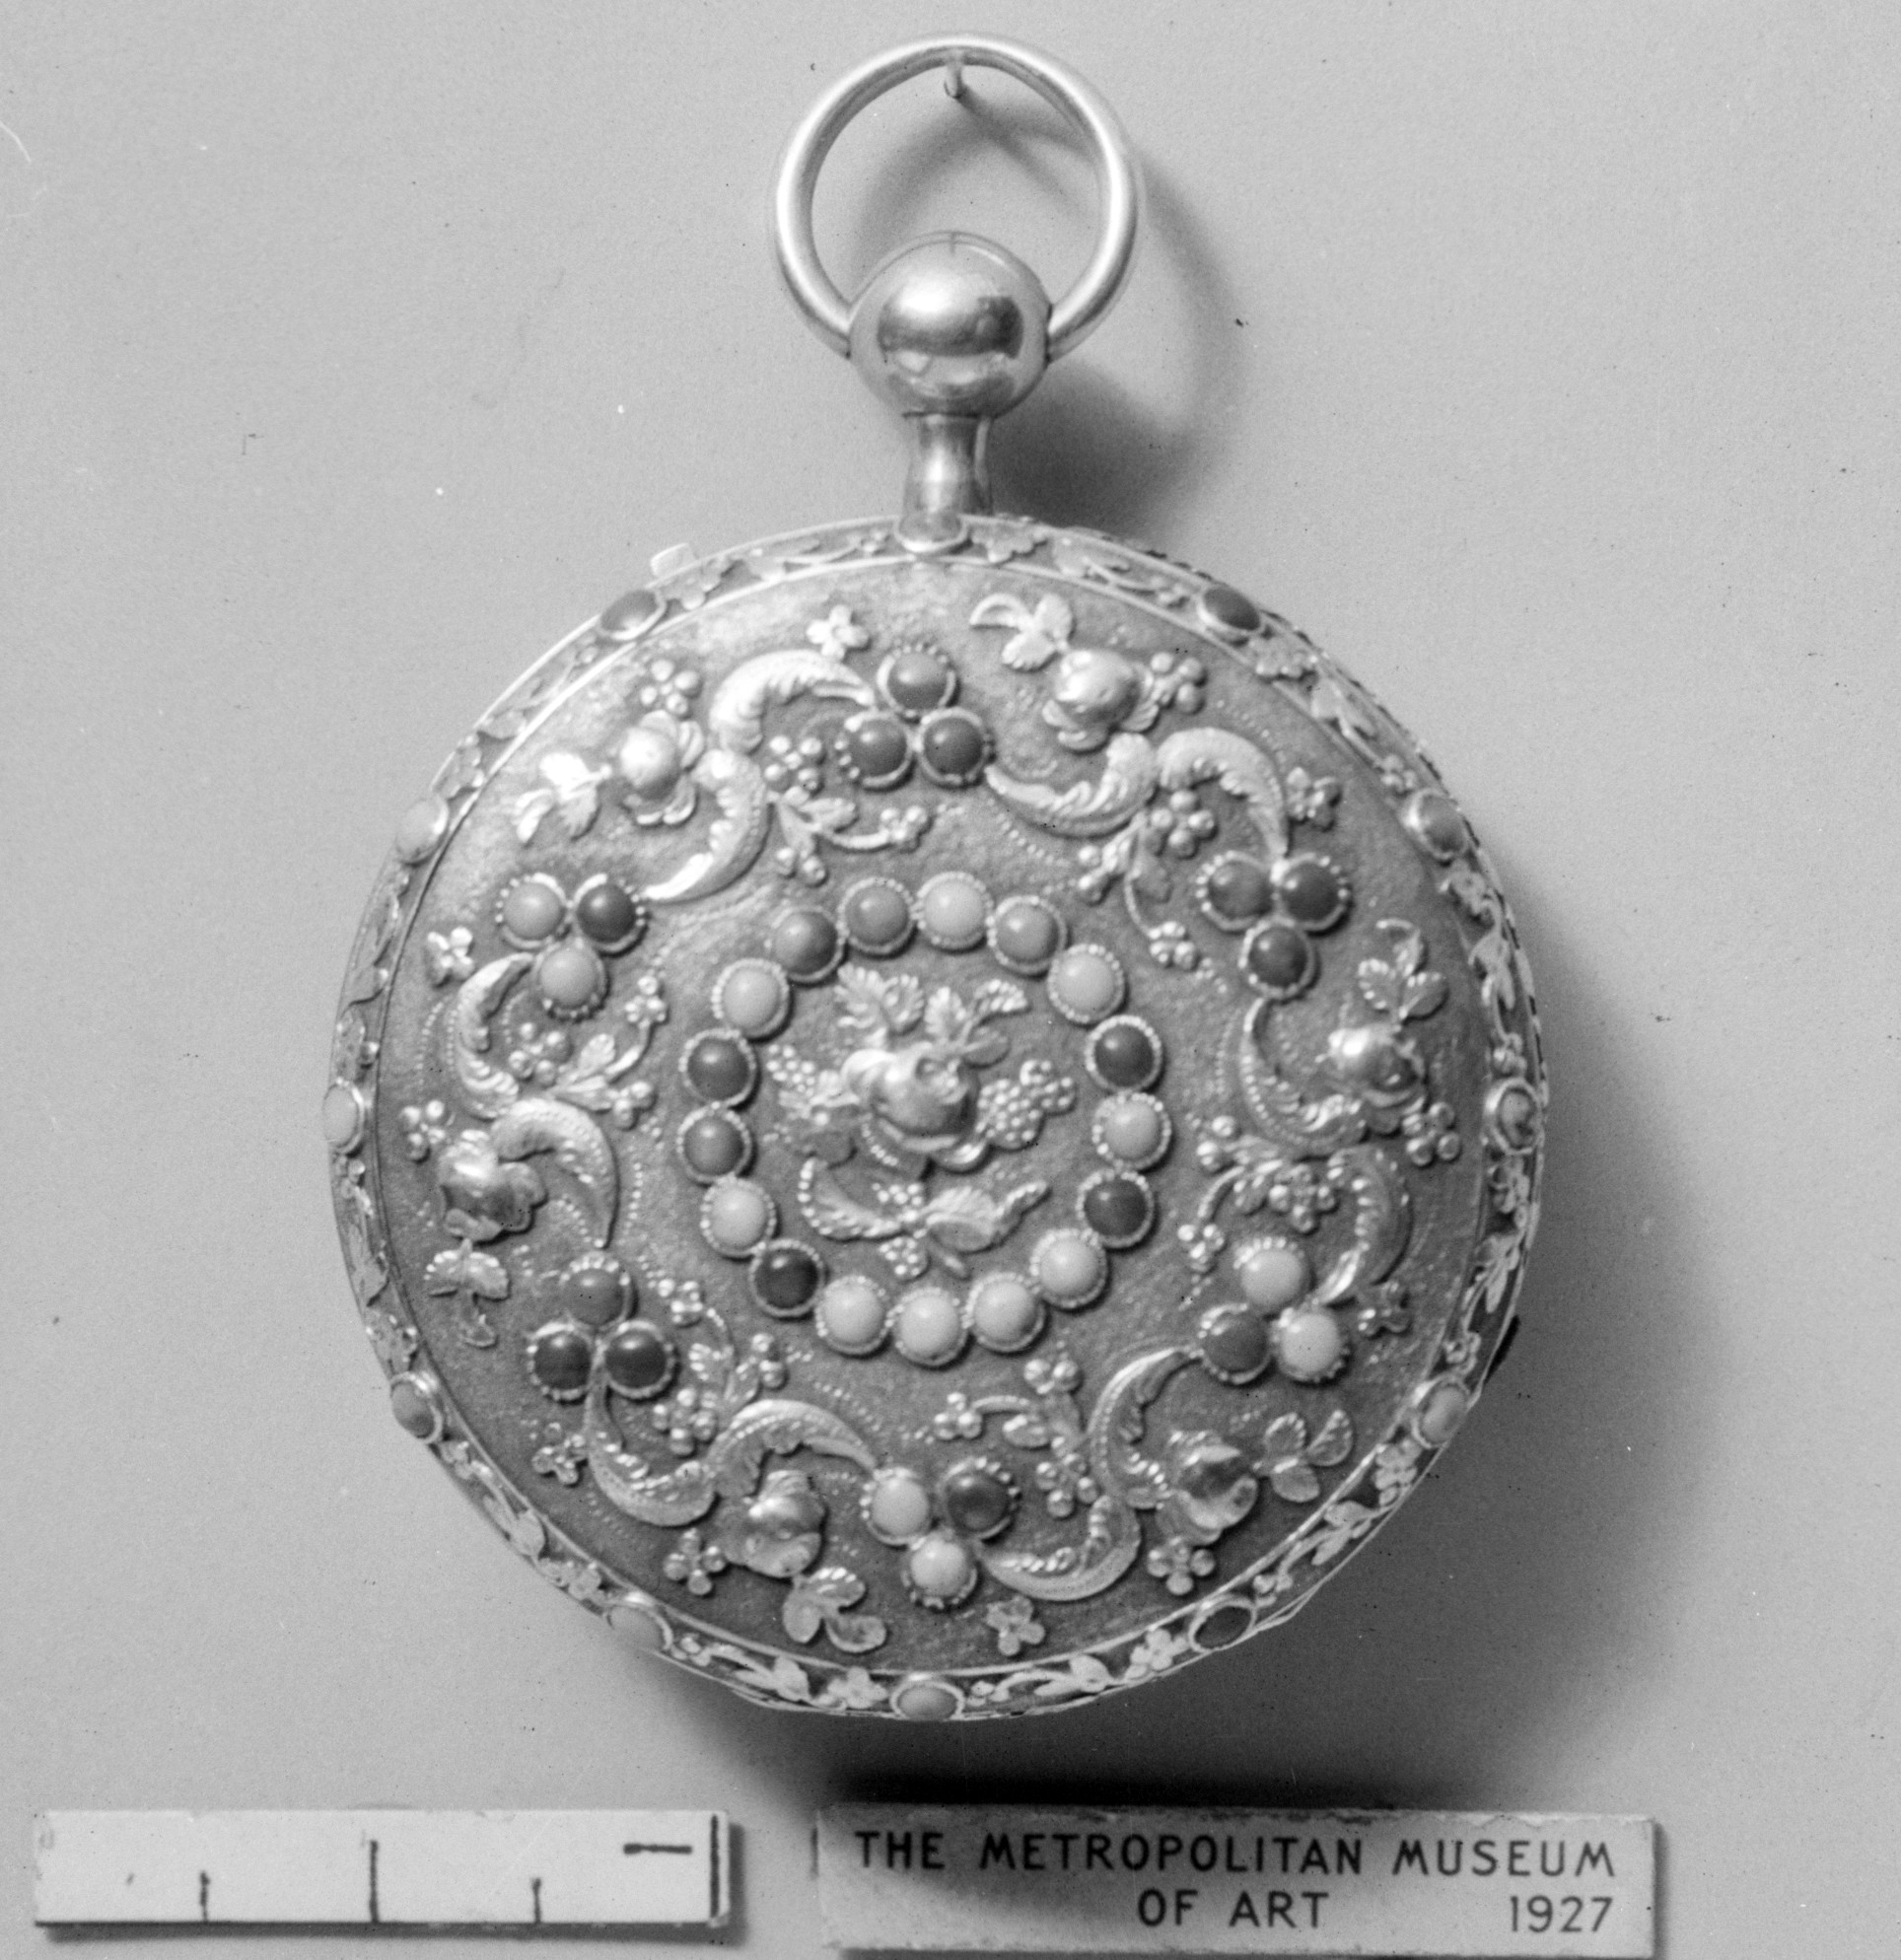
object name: watch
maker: etienne duchène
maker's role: maker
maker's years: 1775-1875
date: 1800-1830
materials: gold, silver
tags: flowers,leaves